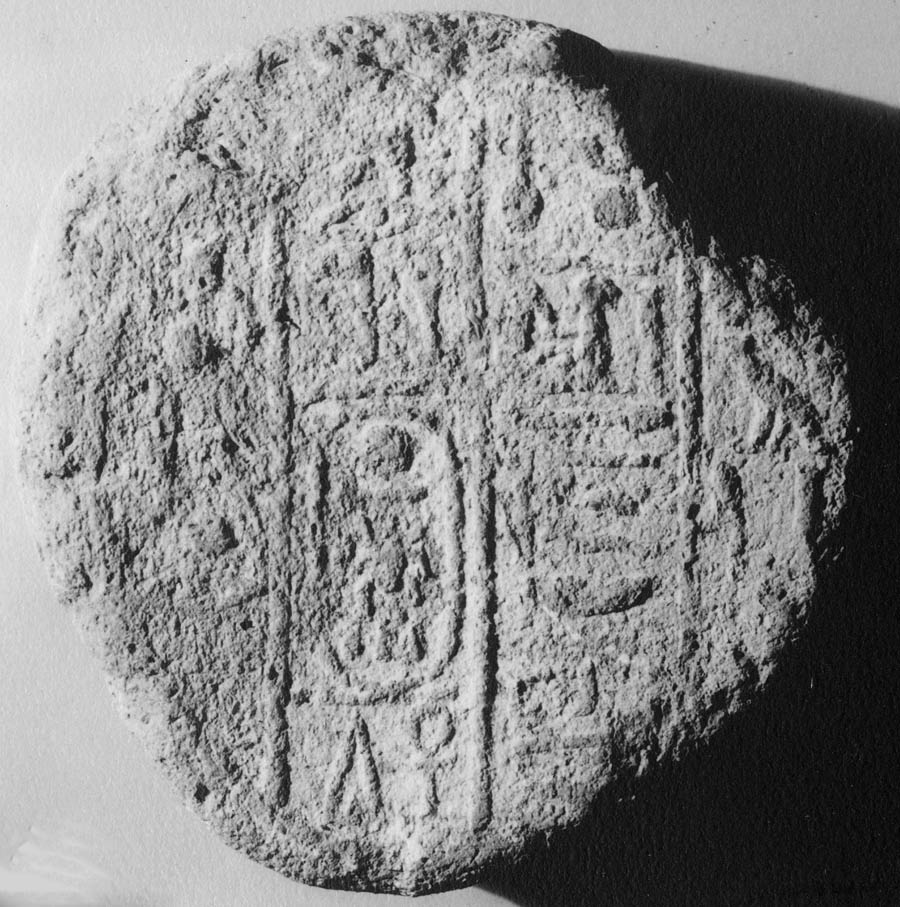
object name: cone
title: Funerary Cone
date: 1550-1295 BCE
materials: pottery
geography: egypt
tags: hieroglyphs